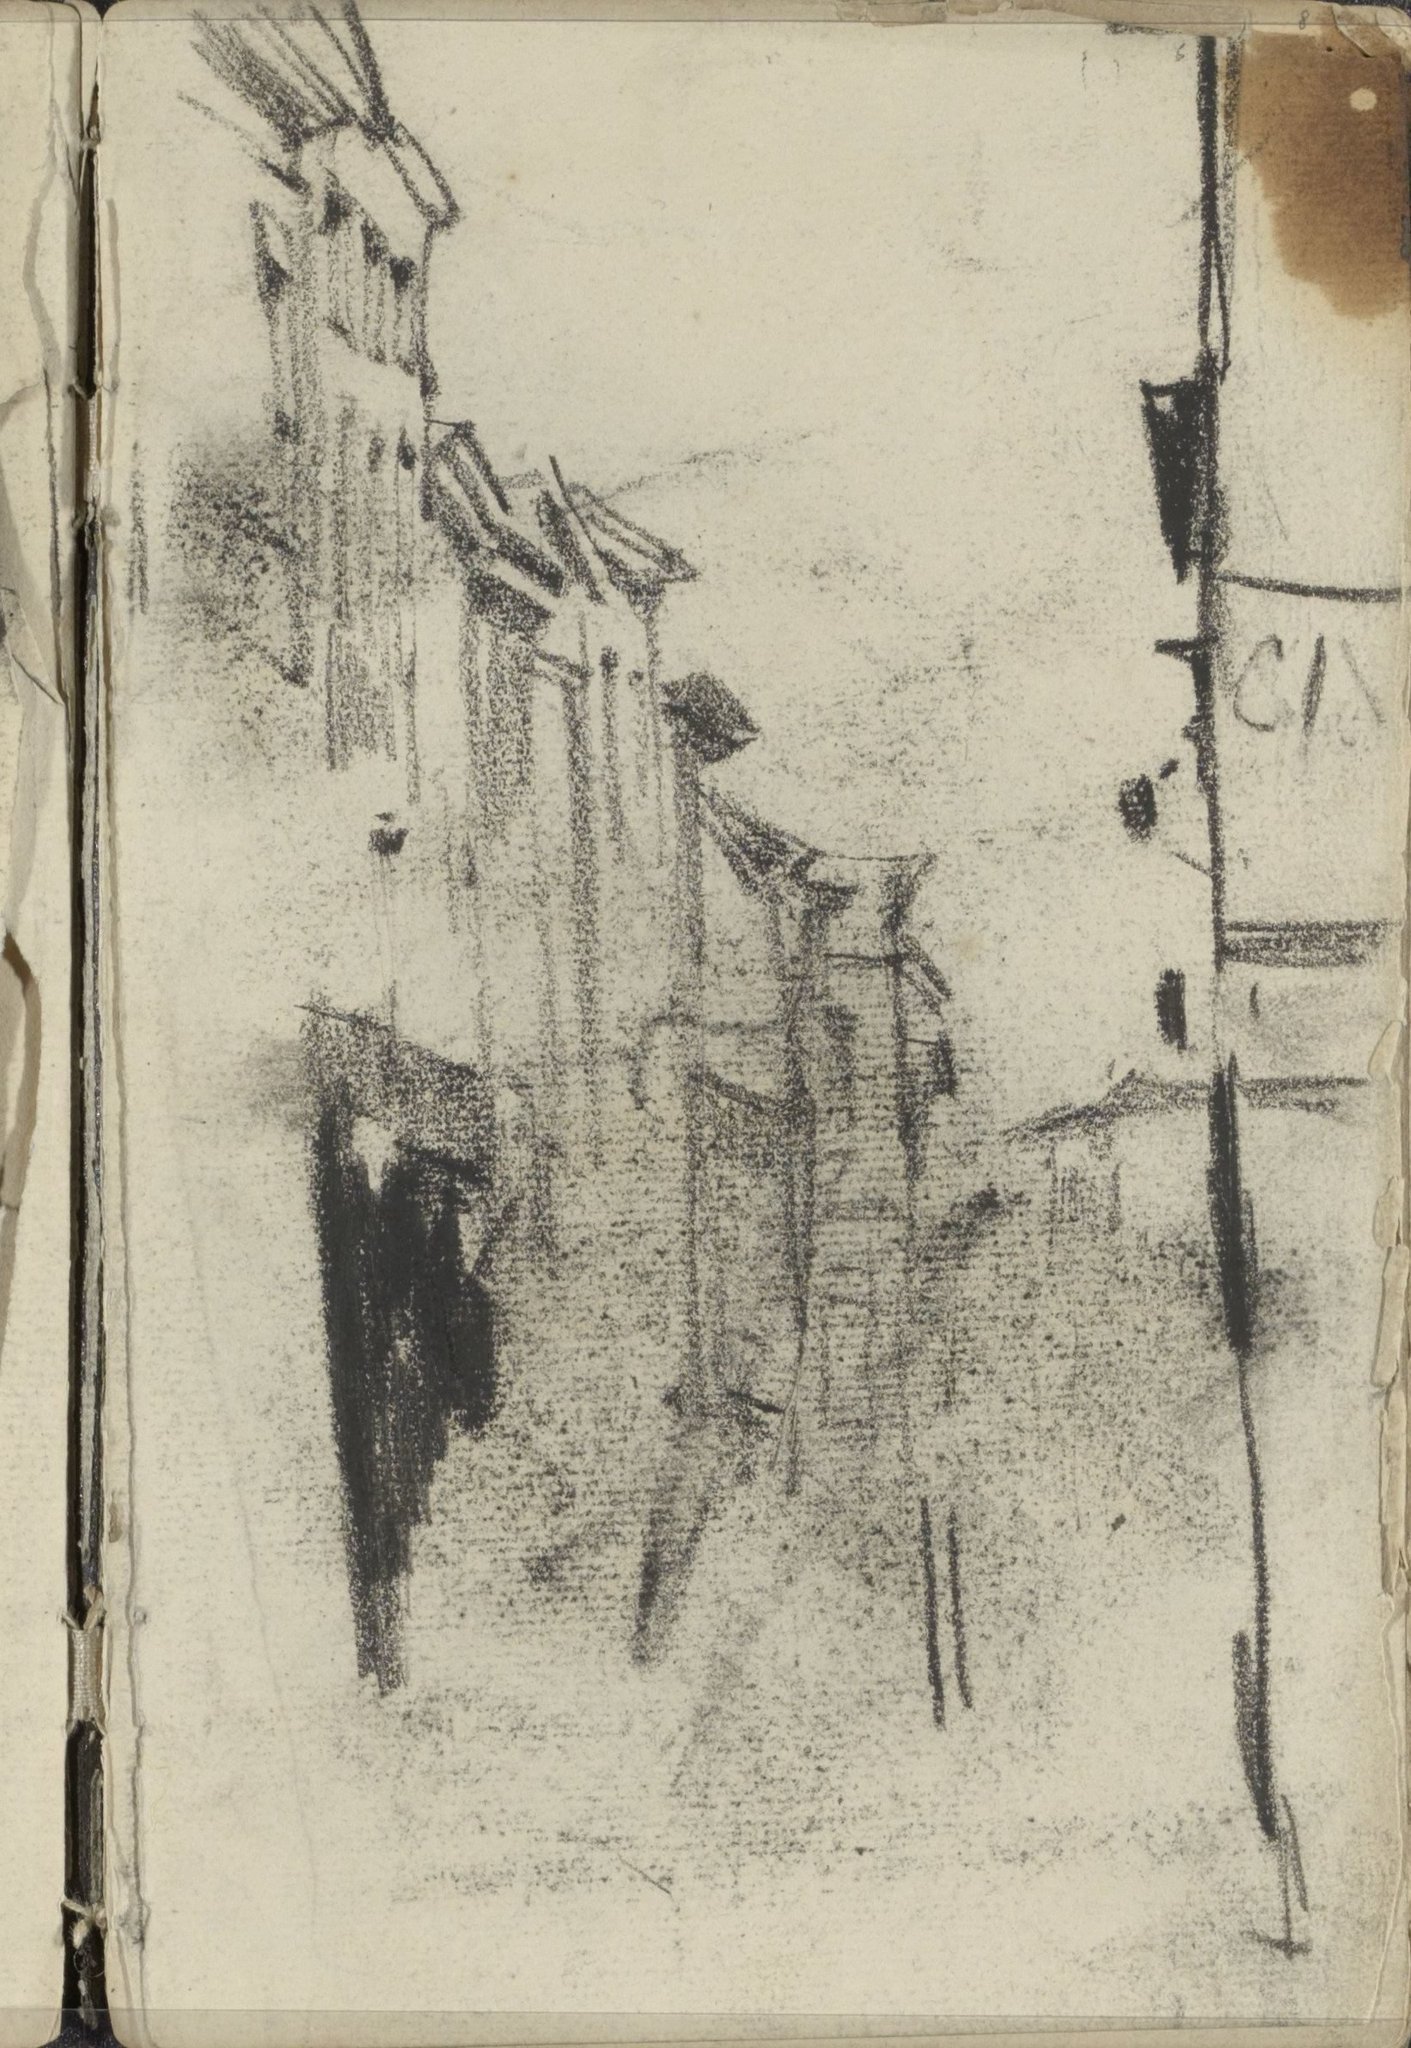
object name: sketchbook leaf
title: Gezicht op een straat in Amsterdam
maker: george hendrik breitner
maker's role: draughtsman, painter, print maker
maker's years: 1857-1923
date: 1887-1891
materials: chalk, paper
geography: amsterdam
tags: street, amsterdam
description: Pagina 6 uit een schetsboek met 17 bladen.